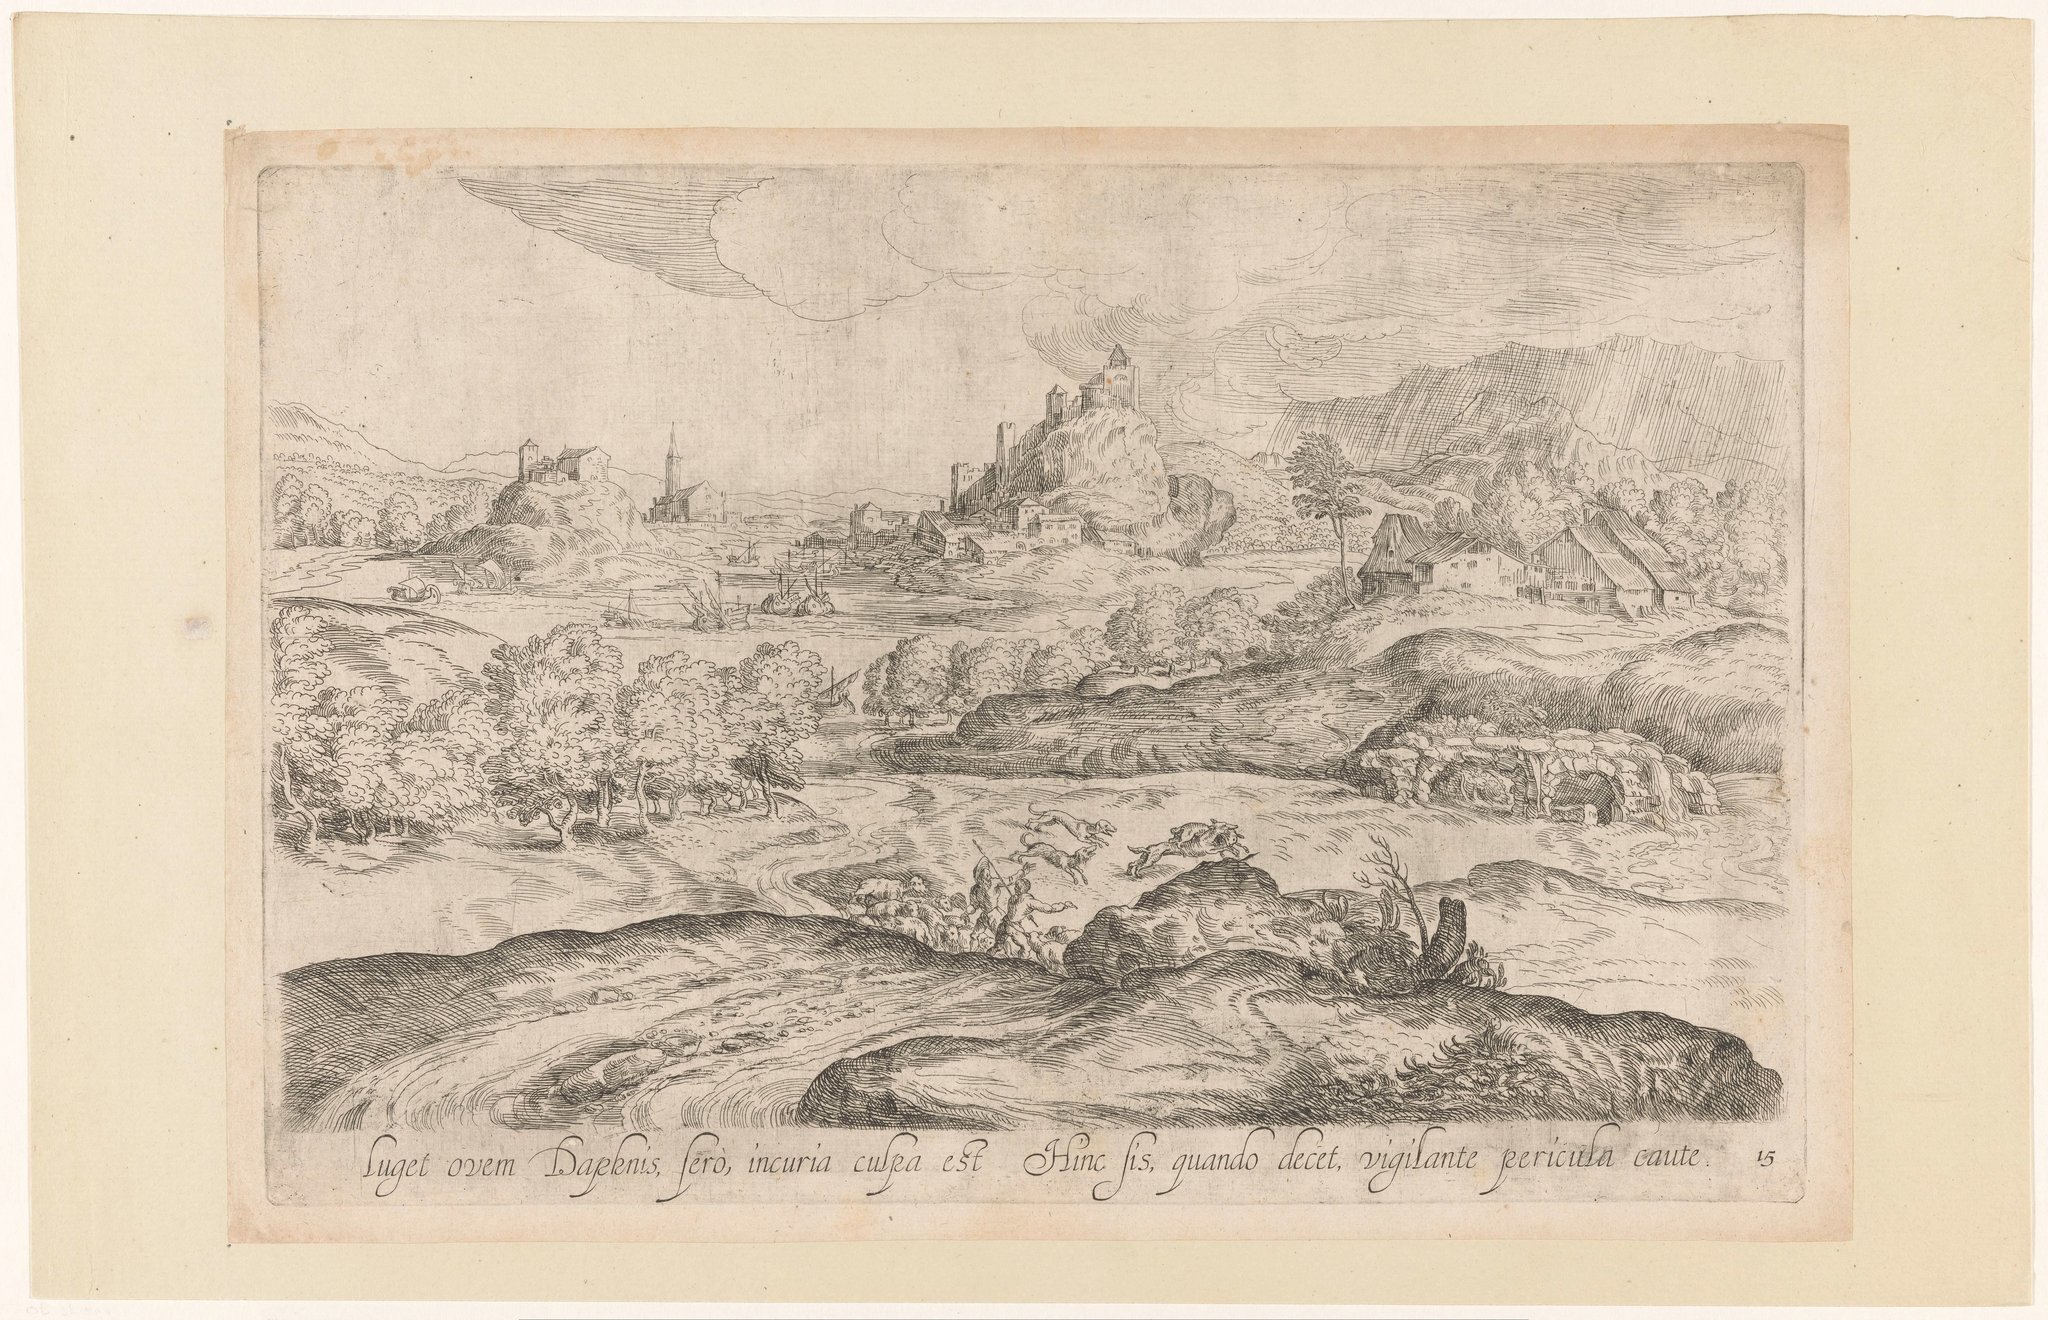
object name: print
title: Luget ovem Daphnis, serò, incuria culpa est/ Hinc sis, quando decet, vigilante pericula caute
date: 1600-1699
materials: paper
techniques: etching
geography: italy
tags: landscapes, herding, herdsman, herdswoman, shepherd, shepherdess, cowherd, etc., herd, flock, beasts of prey, predatory animals: wolf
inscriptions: collector's mark: Lugt 2228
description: Landschap met heuvels en een rivier. Op de voorgrond twee herders met hun kudde schapen. Een wolf valt de kudde aan. Titel in het Latijn in ondermarge. Genummerd rechtsonder: 15.